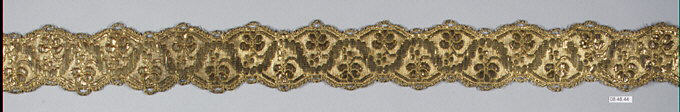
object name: galloon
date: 1701-1800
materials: metal thread